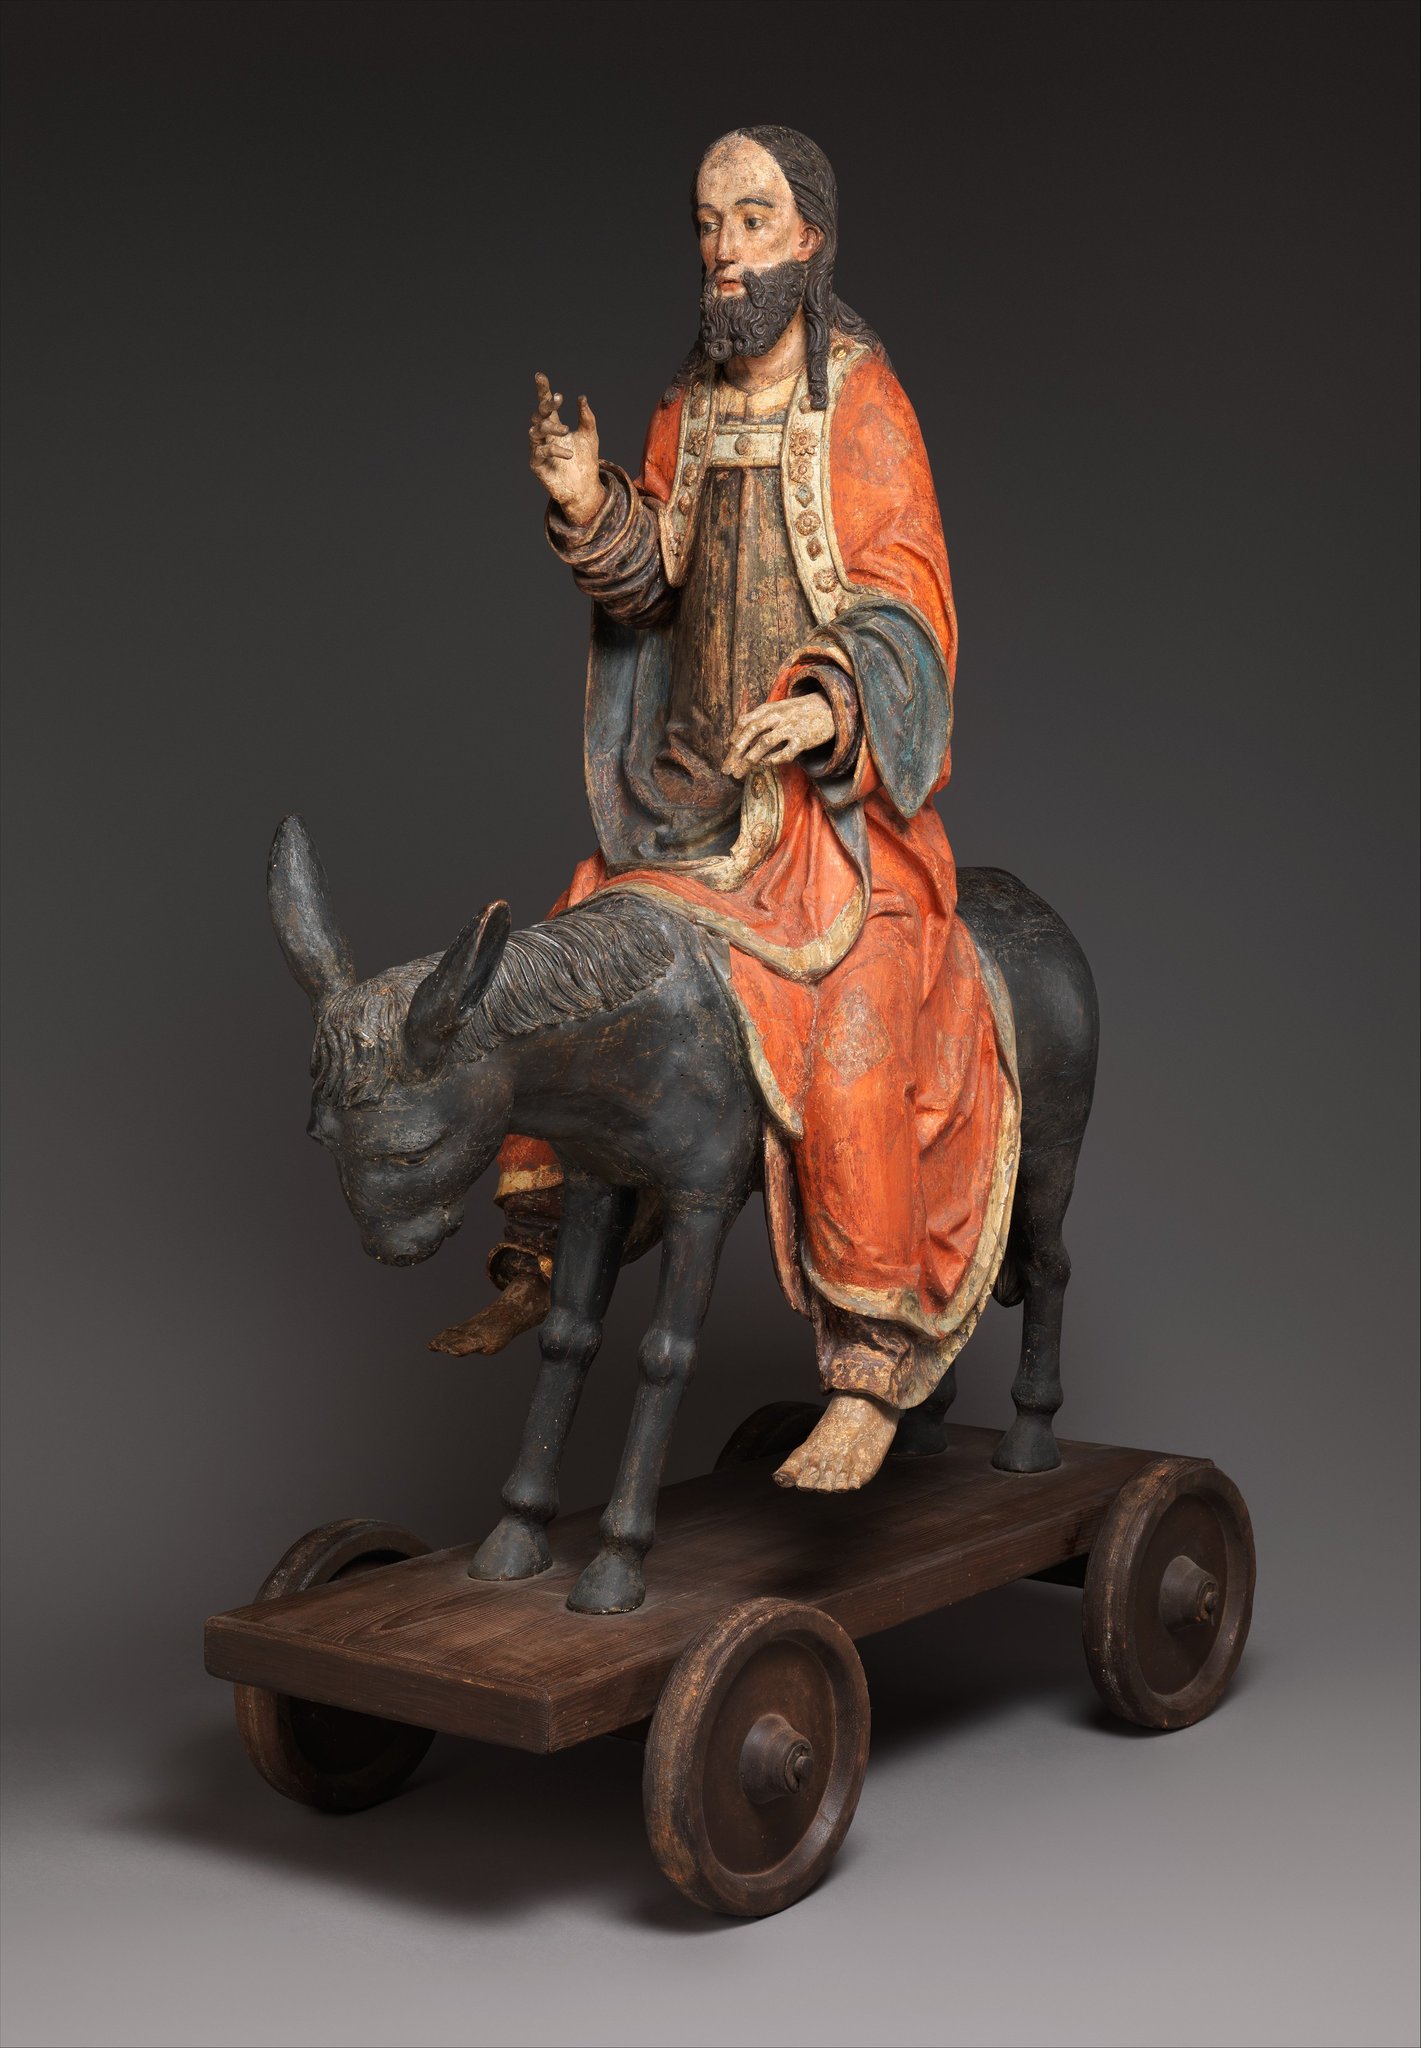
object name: statue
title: Palmesel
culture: german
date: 1401-1500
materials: paint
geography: germany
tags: donkeys,christ